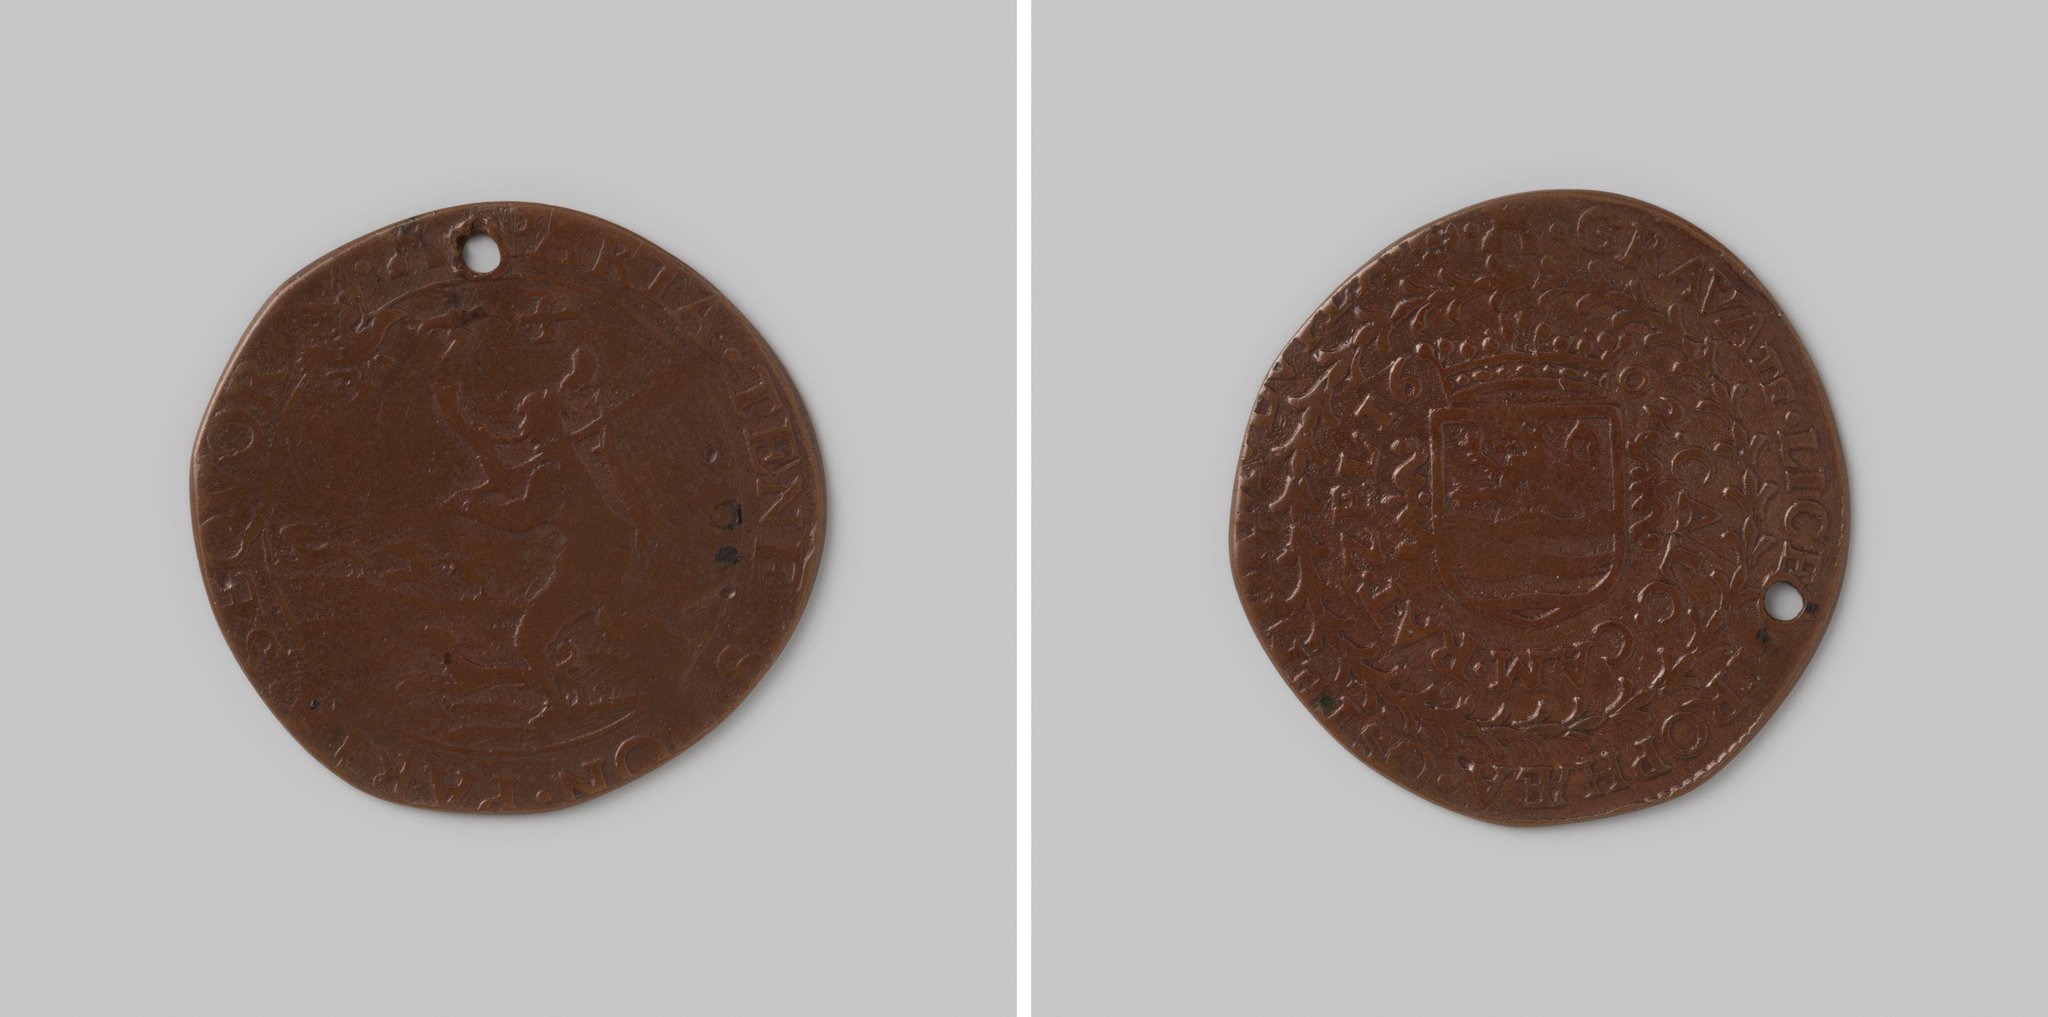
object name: jeton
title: Rekenpenning uit Middelburg voor de Rekenkamer van Zeeland op de overgave van Grave 1602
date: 1602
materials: copper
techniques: striking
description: Koperen penning met doorboring, op de voorzijde een jager met zijn vangst terugkerend, met omschrift, op de keerzijde het gekroonde wapenschild van Zeeland met omschrift binnen een lauwerkrans, met omschrift.